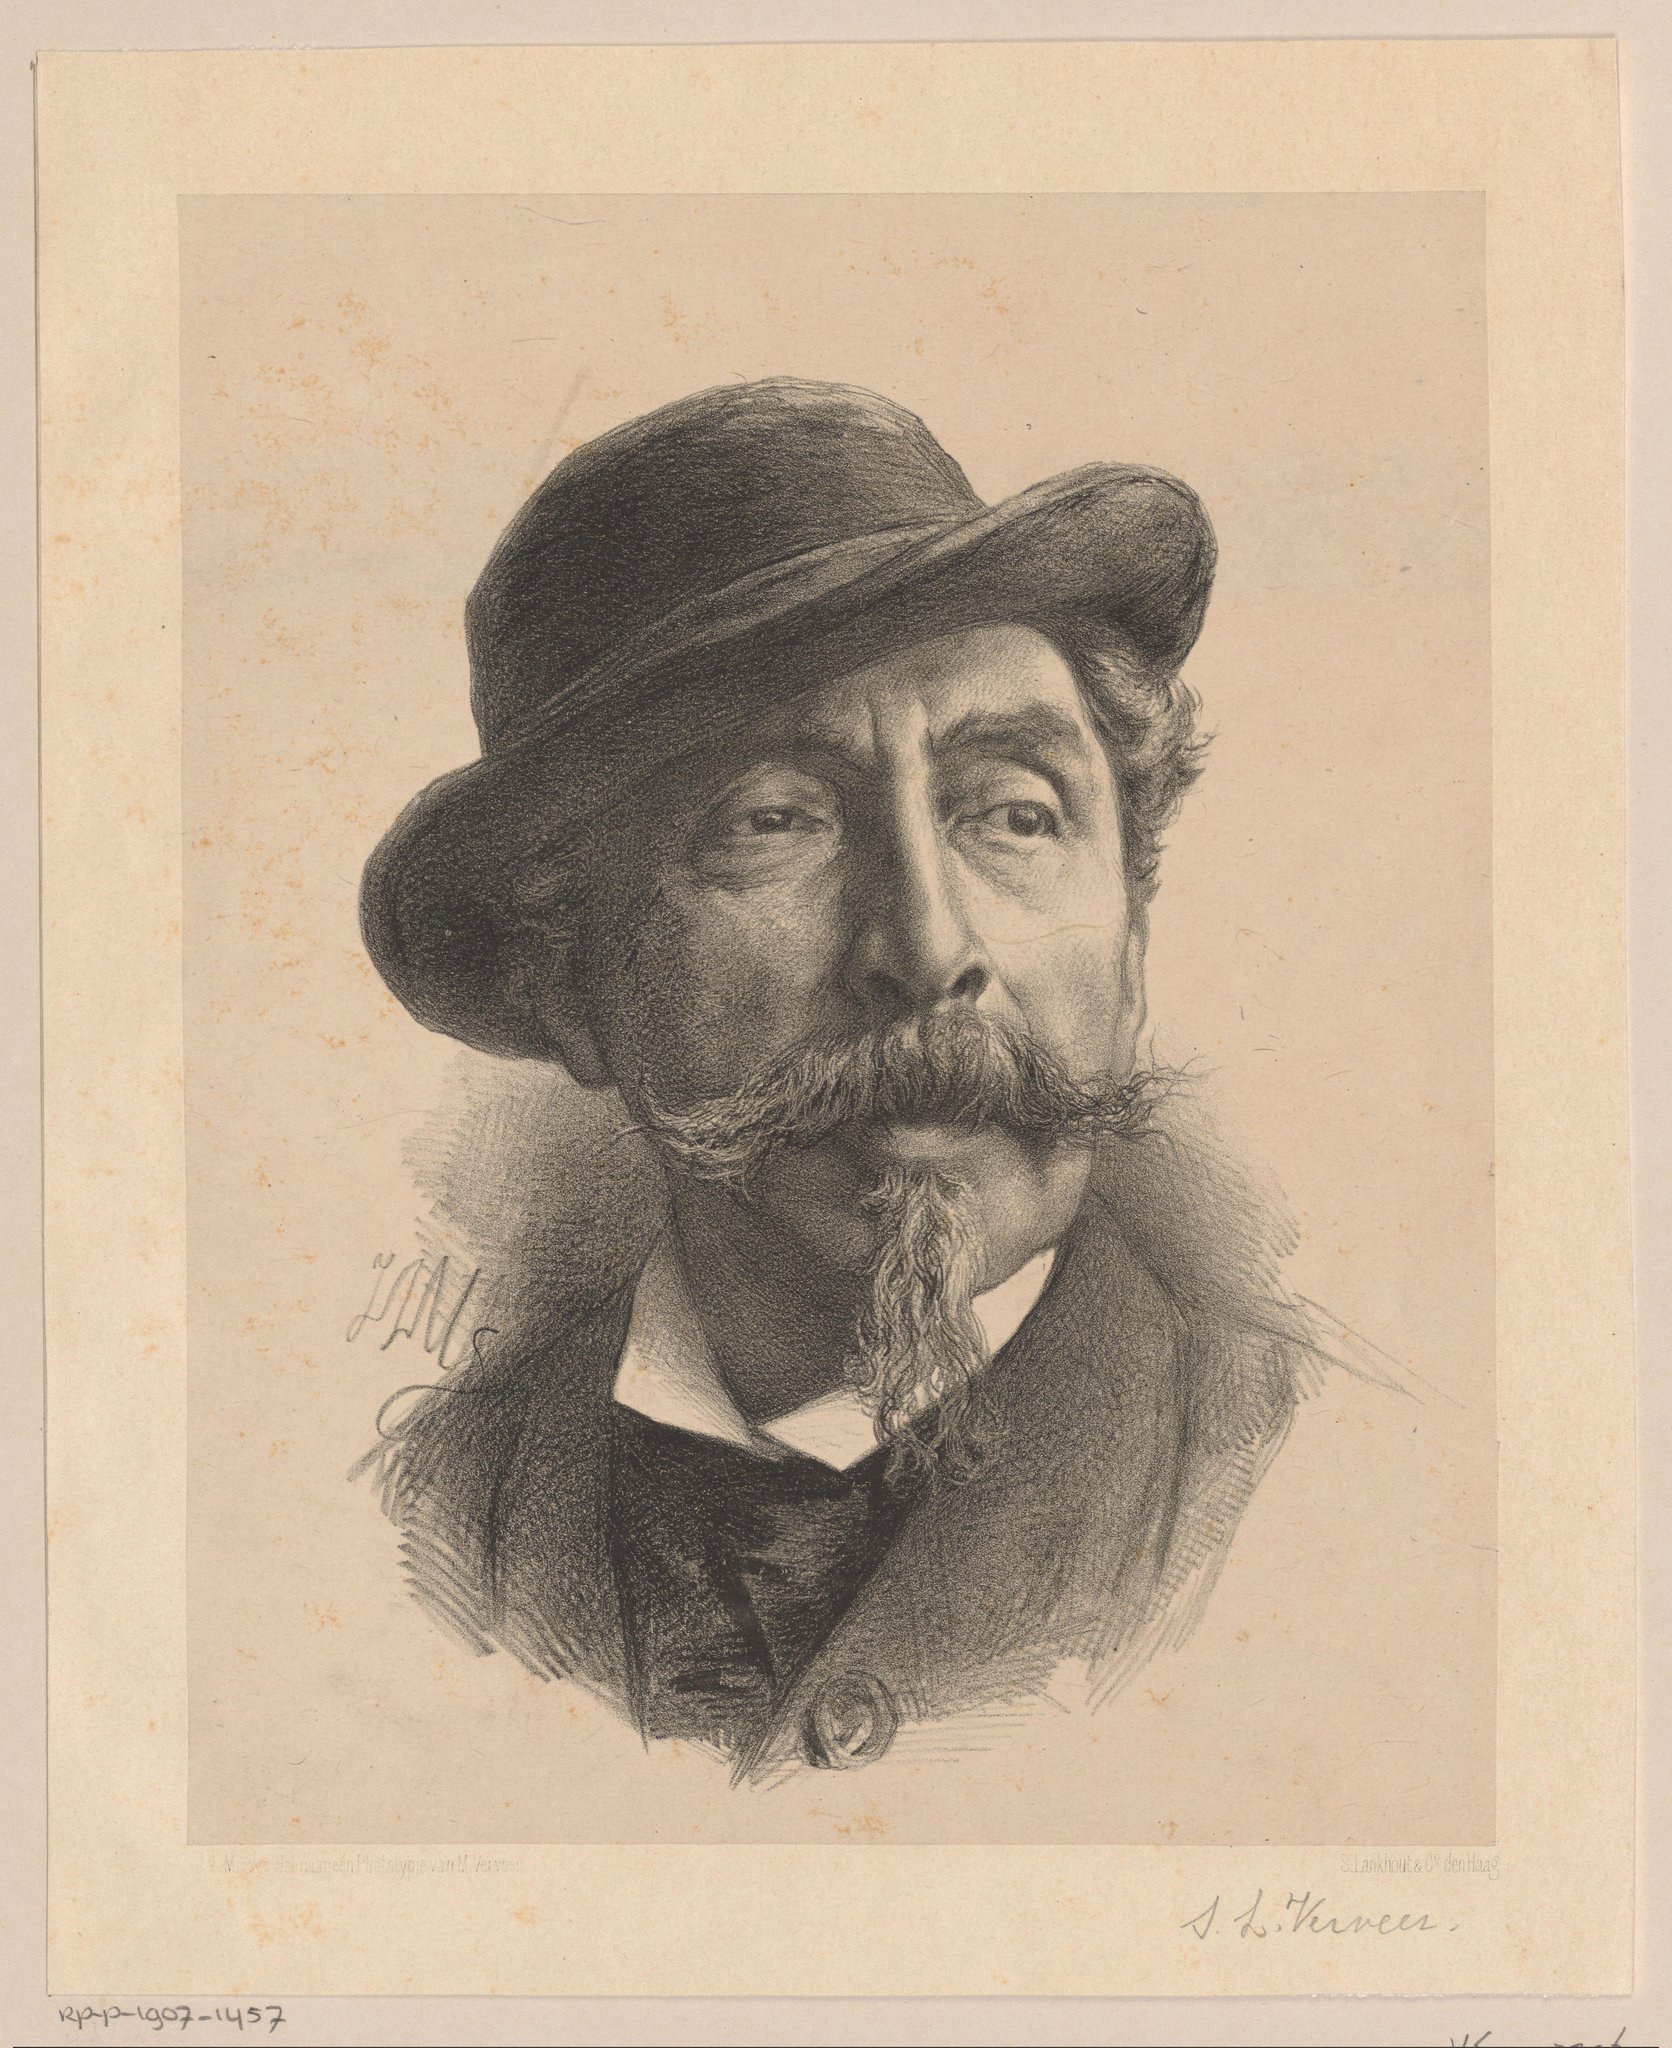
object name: print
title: Portret van Salomon Leonardus Verveer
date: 1867-1874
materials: paper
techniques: lithograph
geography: the hague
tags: the hague, salomon leonardus verveer, historical persons, portrait, self-portrait of painter, portrait, self-portrait of graphic artist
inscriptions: collector's mark: Lugt 2228